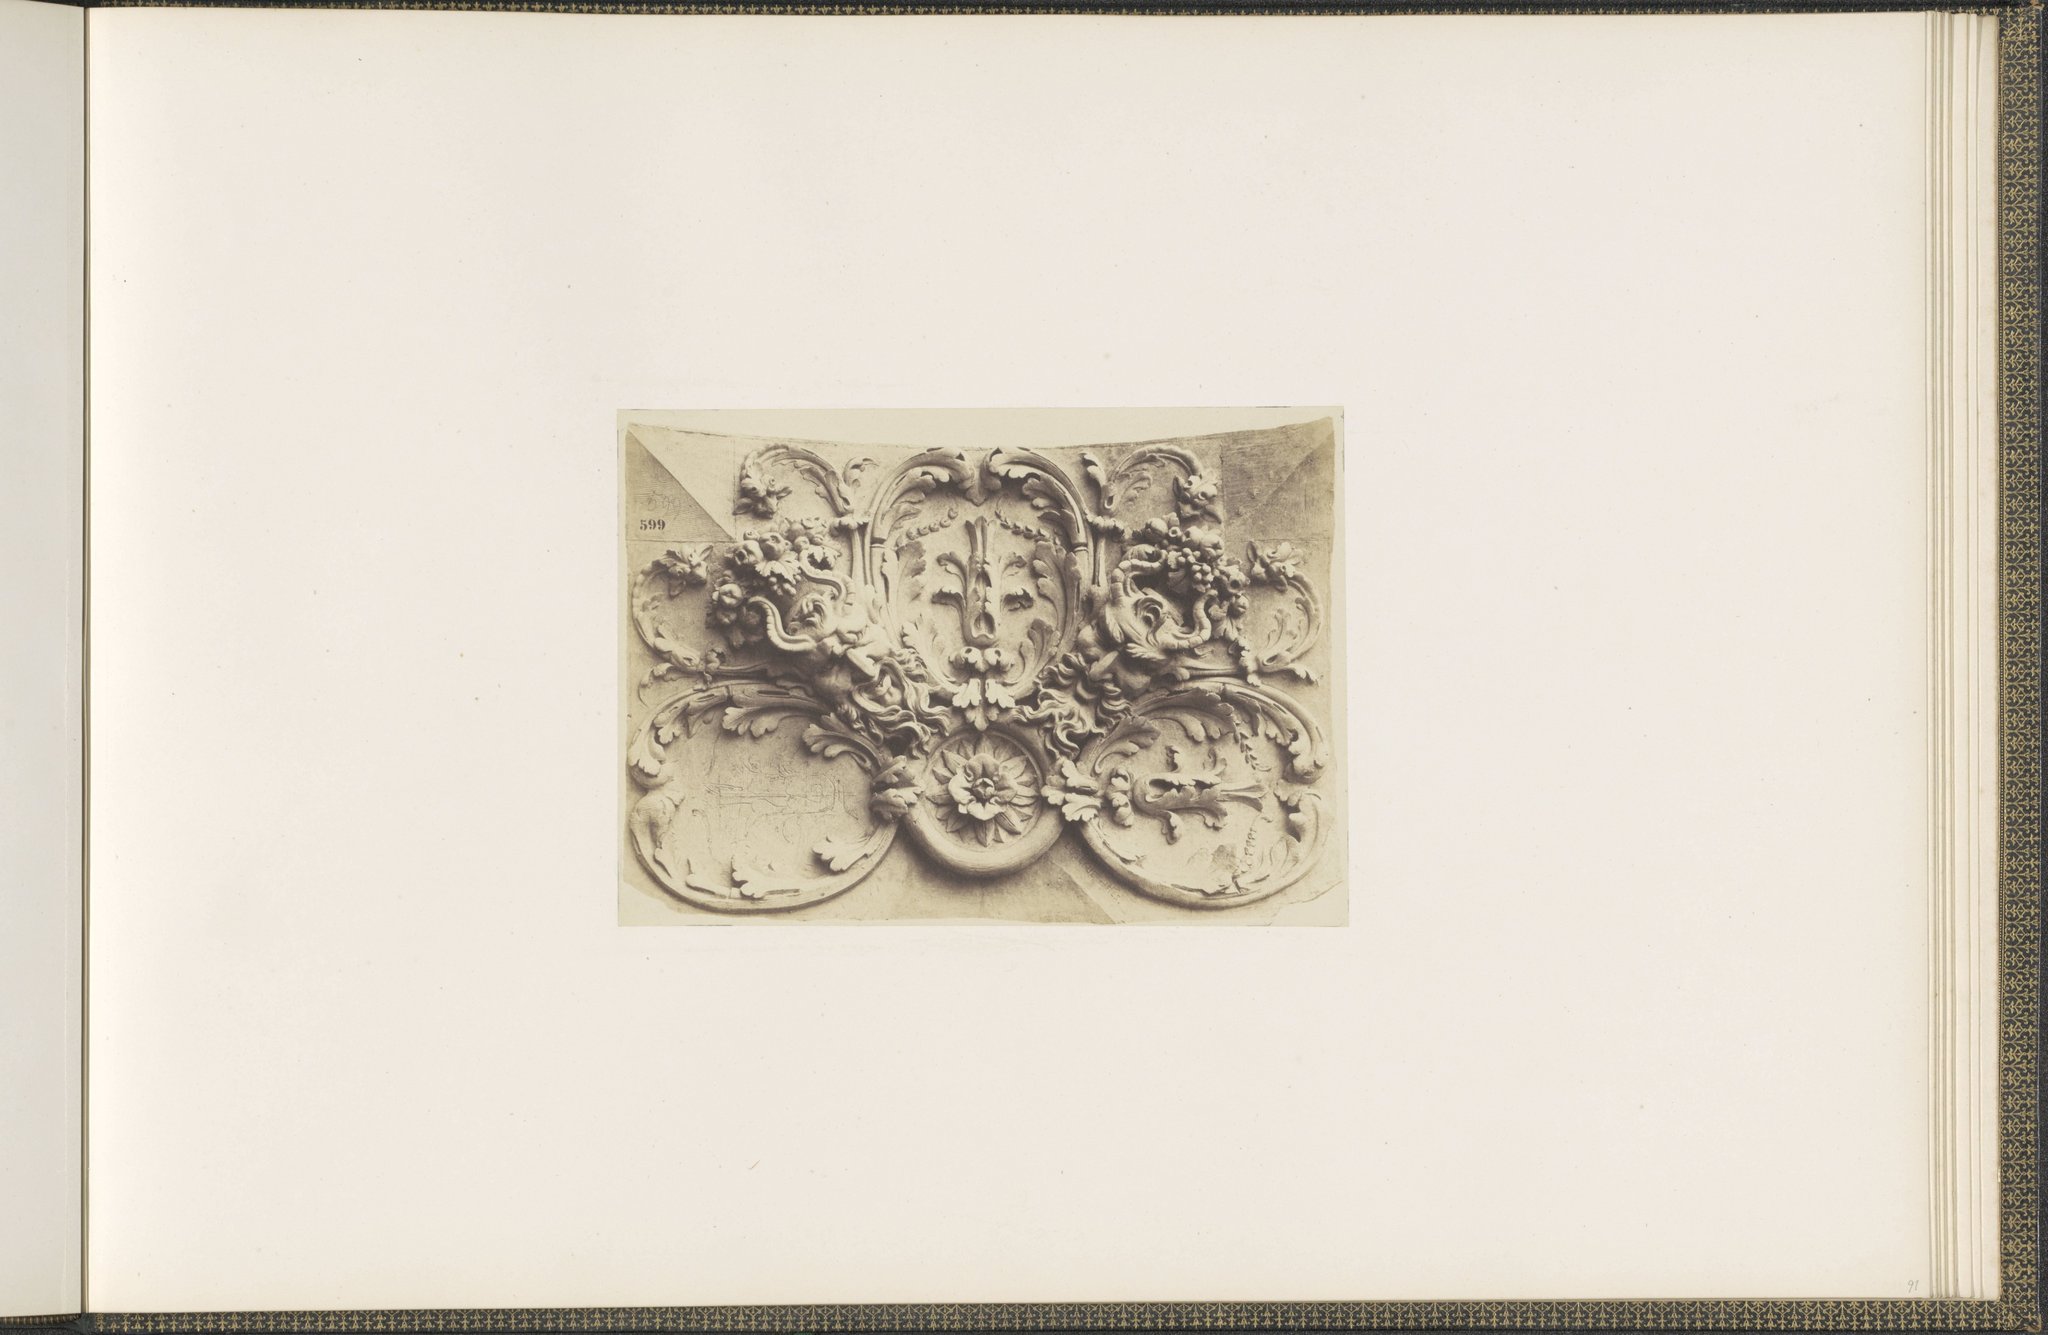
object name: album leaf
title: Gipsmodel voor een versiering van het Palais du Louvre door Lebègue et fils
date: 1855-1857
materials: paper, photographic support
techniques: salted paper print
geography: paris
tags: permanent exhibition, museum, ornamenting, decorating ~ applied arts, paris, tuileries palace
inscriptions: number: ‘599’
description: Onderdeel van Réunion des Tuileries au Louvre 1852-1857, album 4.